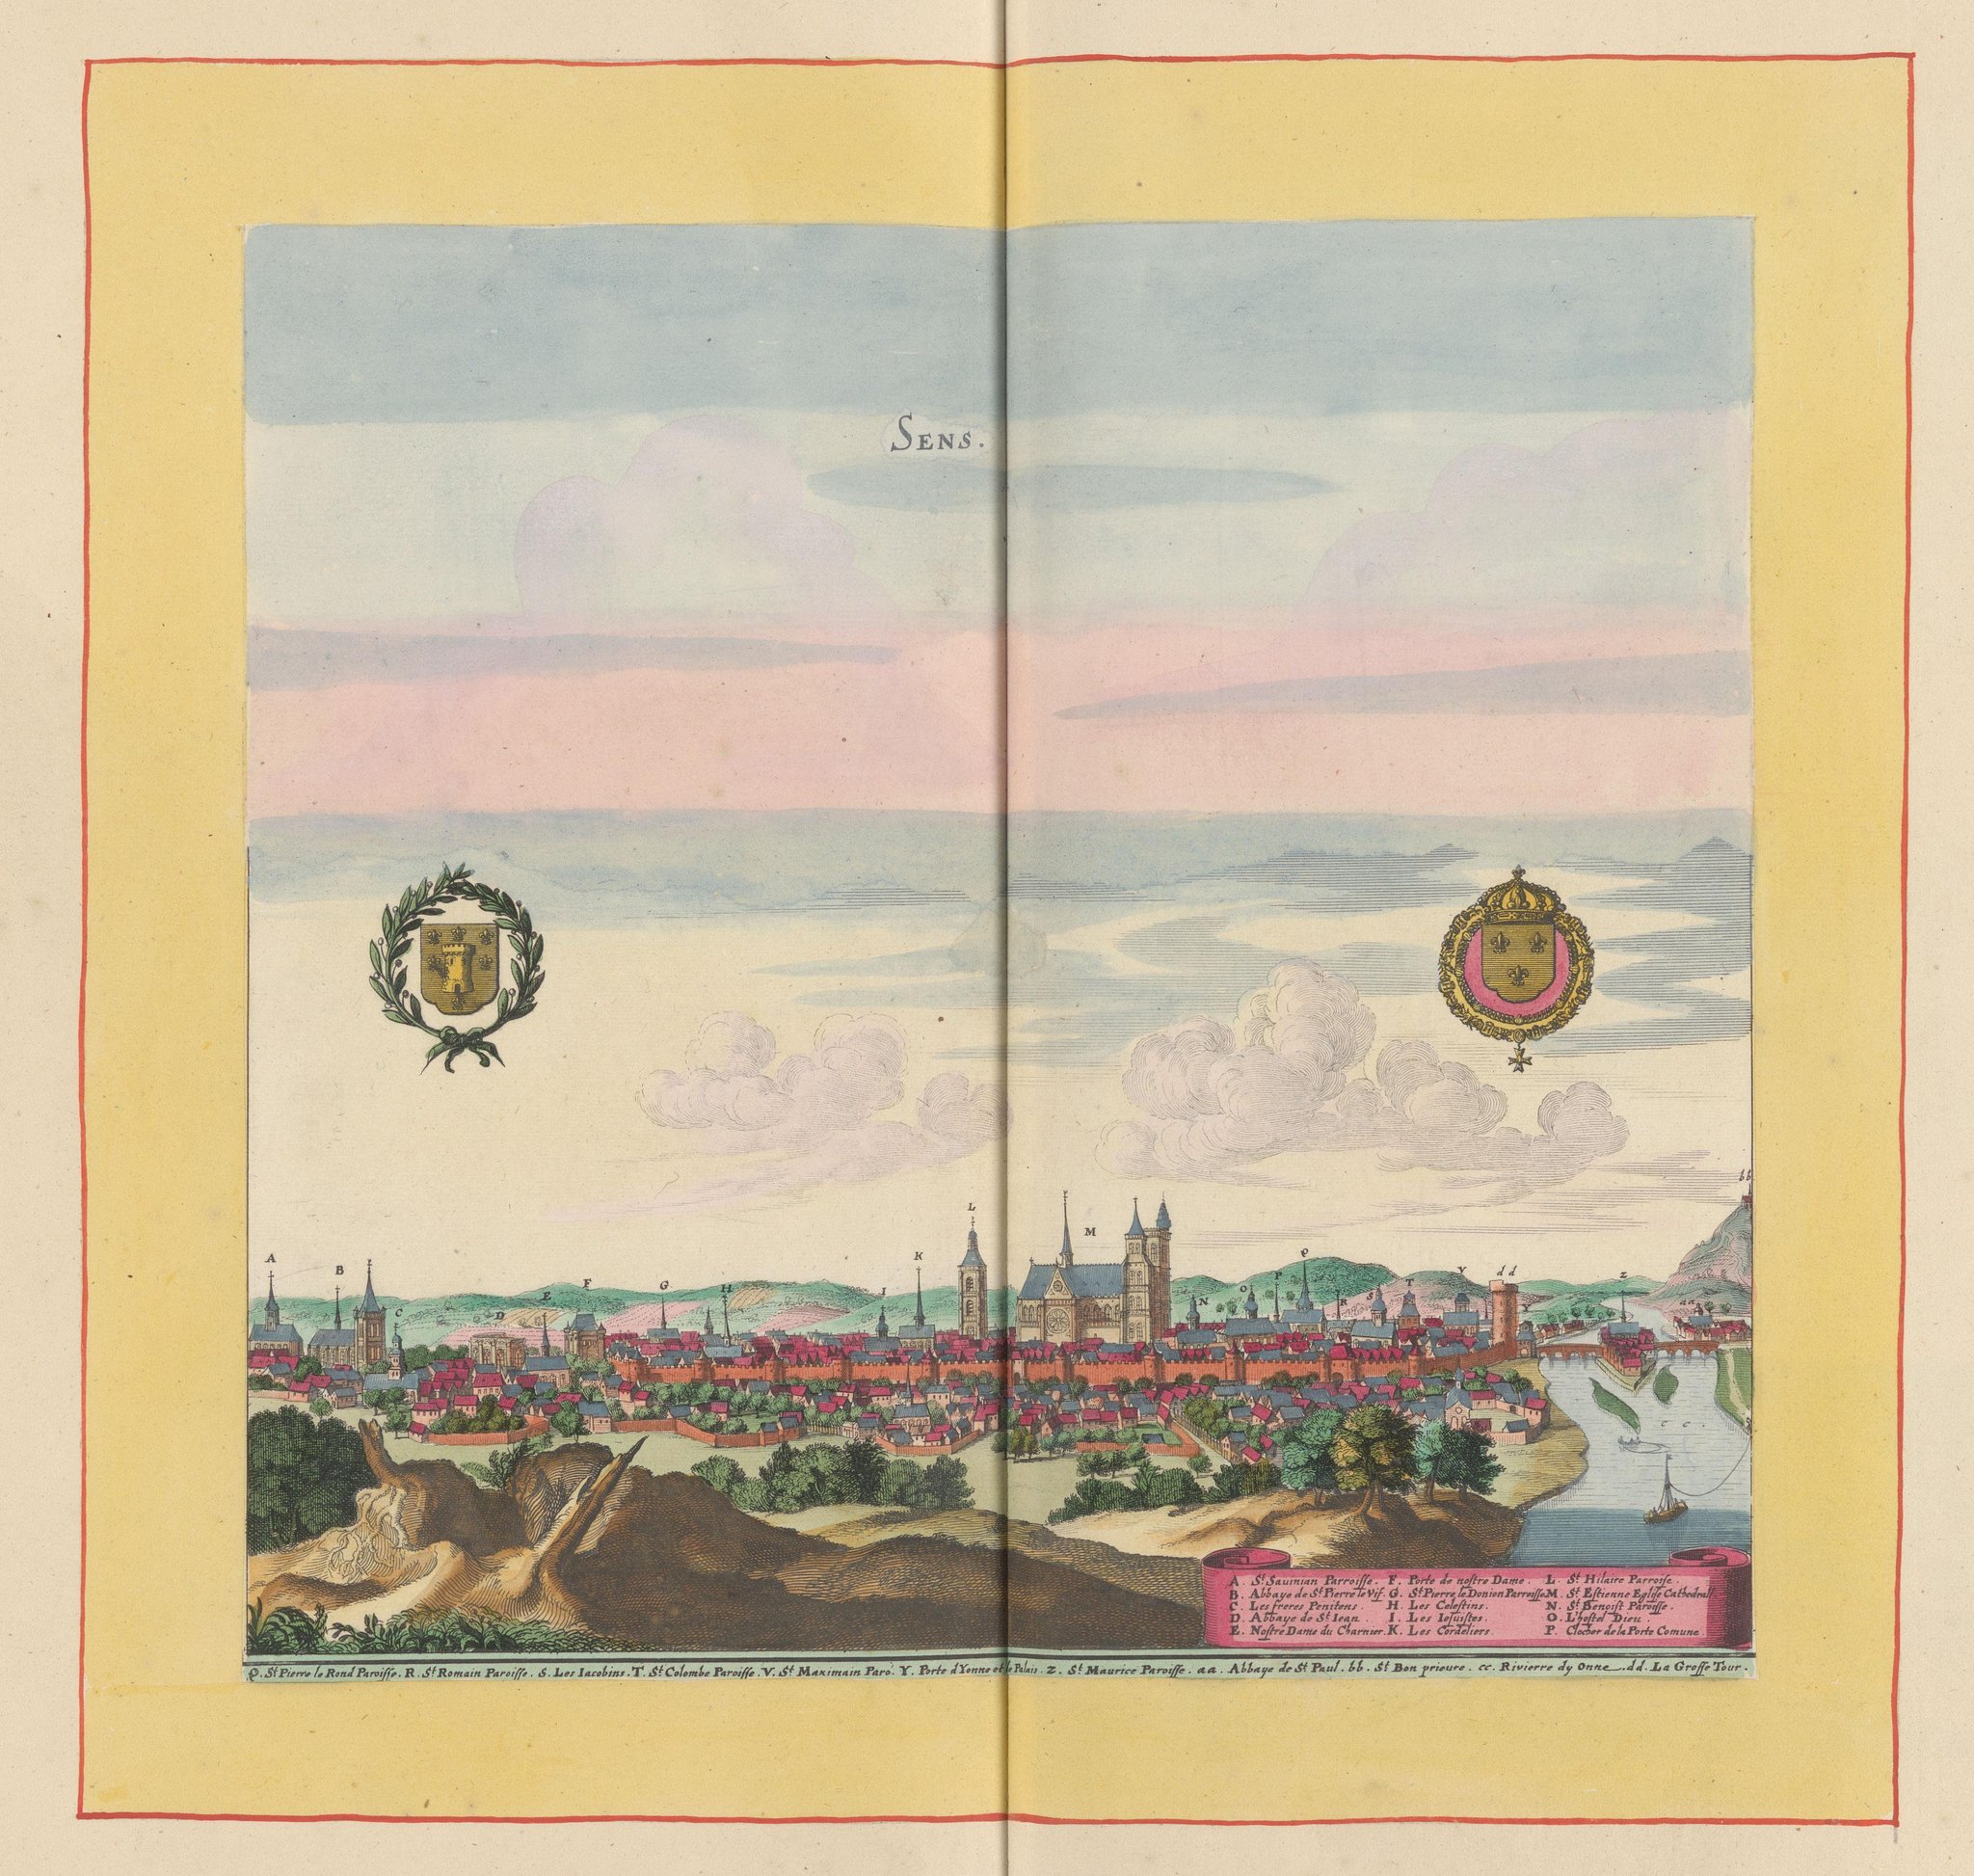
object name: print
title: Gezicht op Sens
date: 1656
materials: paper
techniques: engraving, etching, hand coloring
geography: the hague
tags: city-view in general; 'veduta'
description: Prent uit: Zeiller, Martin. Topographia Galliae. 13 dln. Frankfurt: Caspar Merian, 1656, dl. 3, na p. 30.